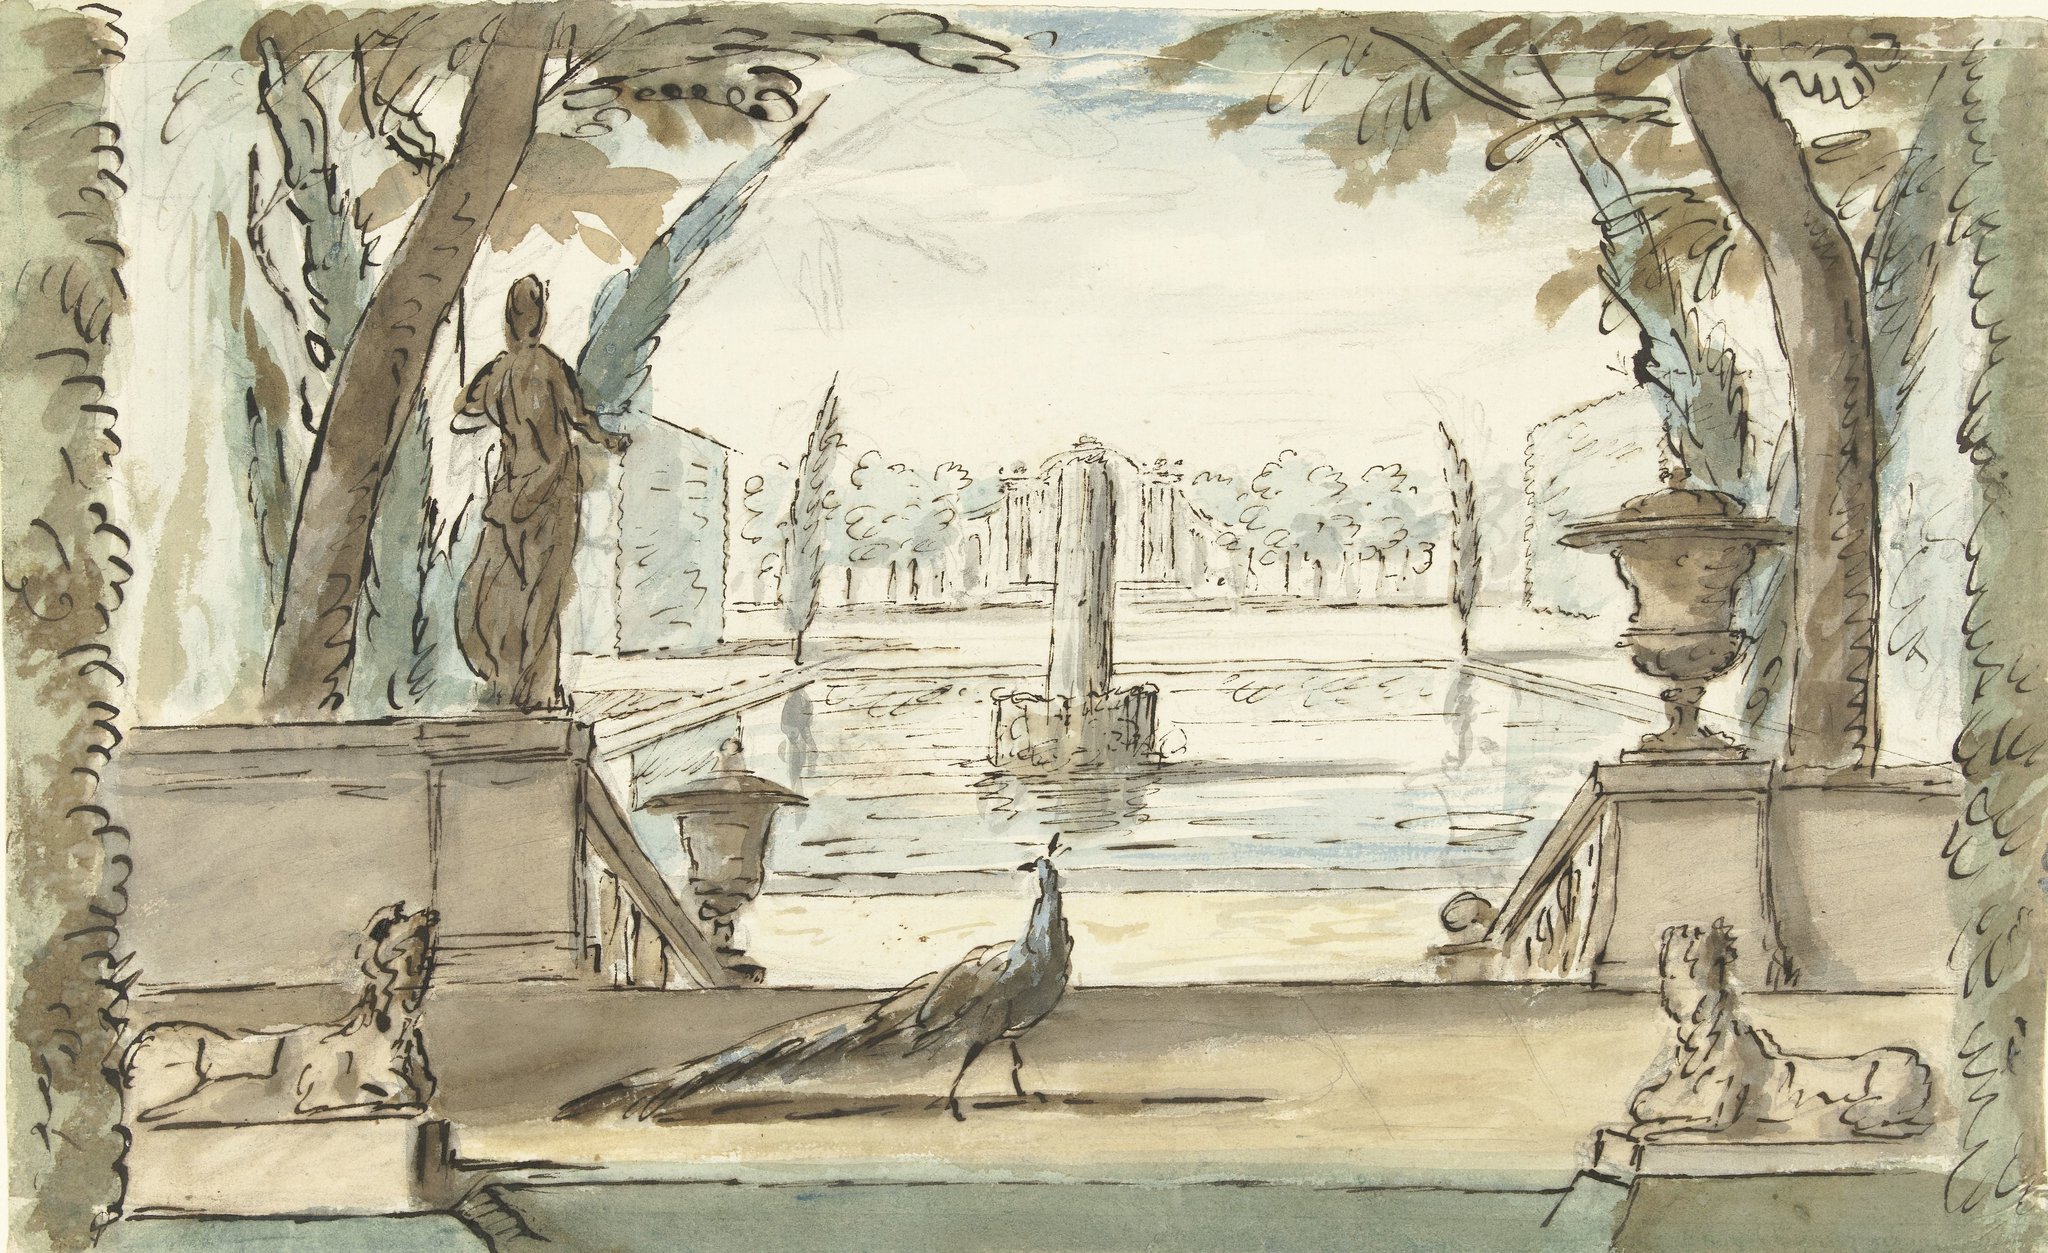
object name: design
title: Gezicht in een tuin met een vijver, een fontein en een pauw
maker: elias van nijmegen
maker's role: draughtsman, painter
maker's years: 1667-1755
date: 1677-1755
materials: ink, paper, pencil, watercolor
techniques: brush, pen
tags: garden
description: Gezicht in een tuin met een vijver en een fontein, op de voorgrond een pauw. Ontwerp voor een schildering.